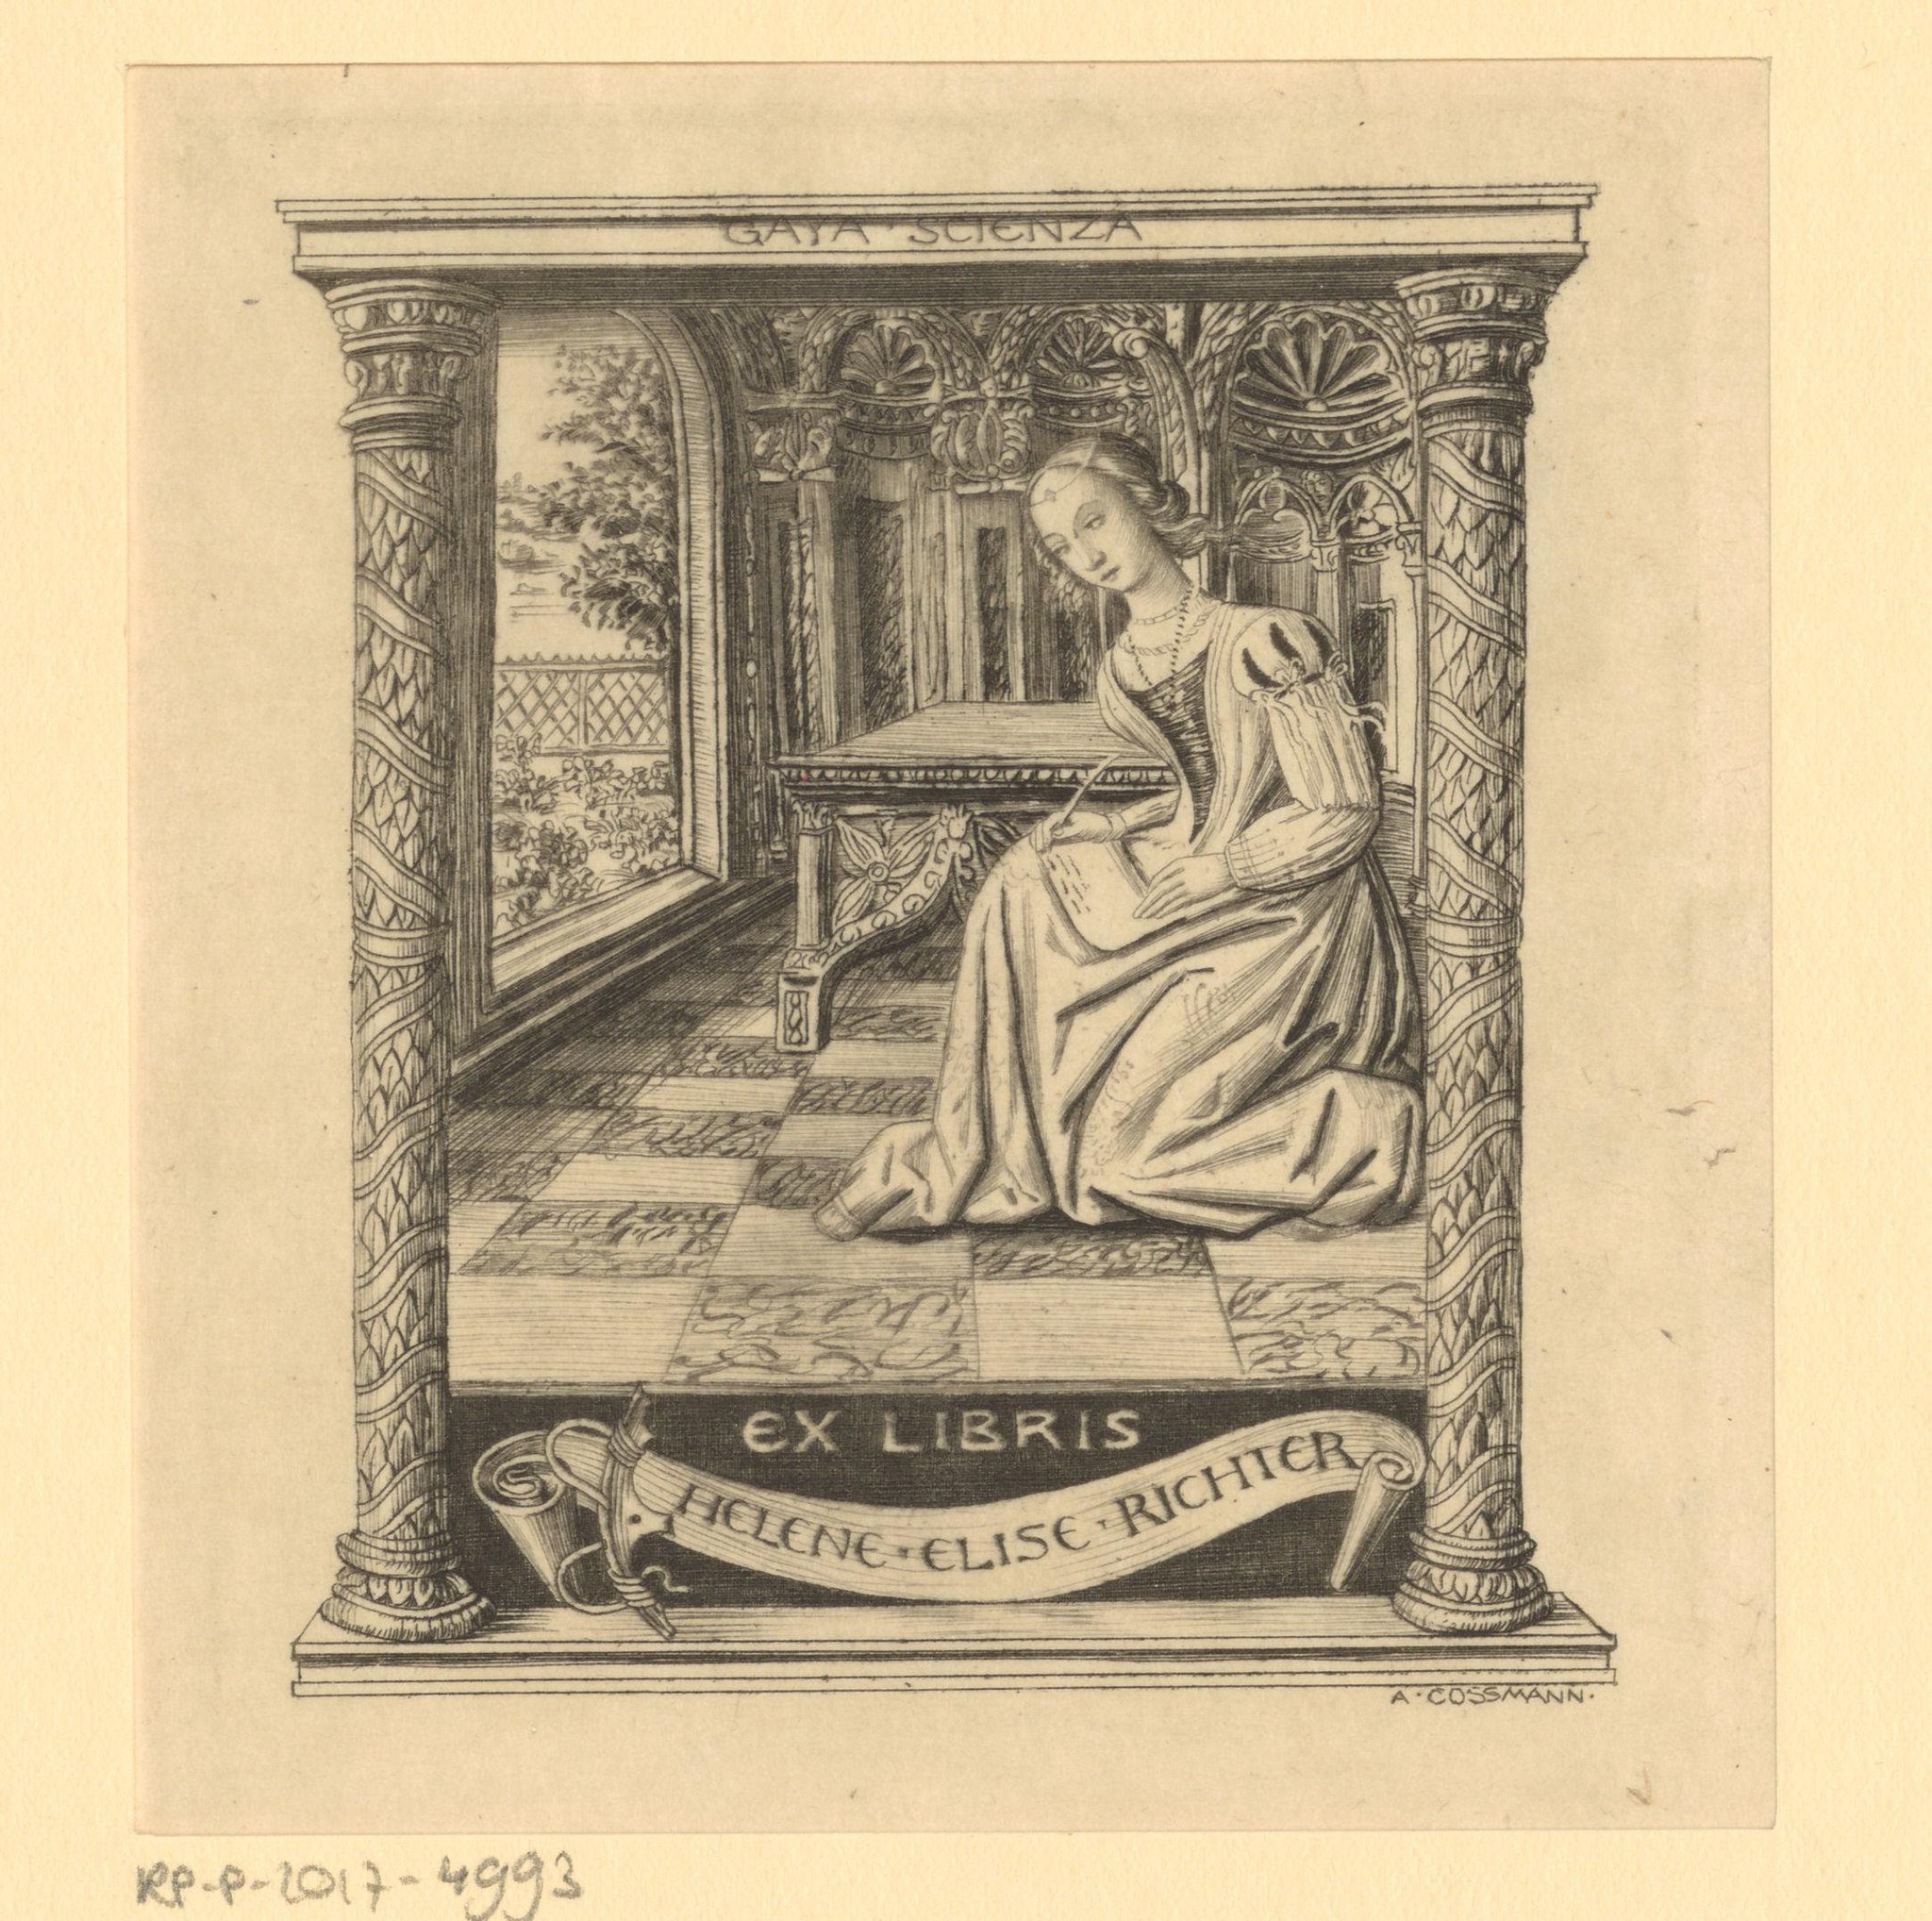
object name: bookplate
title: Gaya scienza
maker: alfred cossmann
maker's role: print maker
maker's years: 1870-1951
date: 1907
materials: paper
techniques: drypoint, etching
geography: austria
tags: vienna, sitting figure - aa - female human figure, column, pillar ~ architecture, writing tools, historical costume